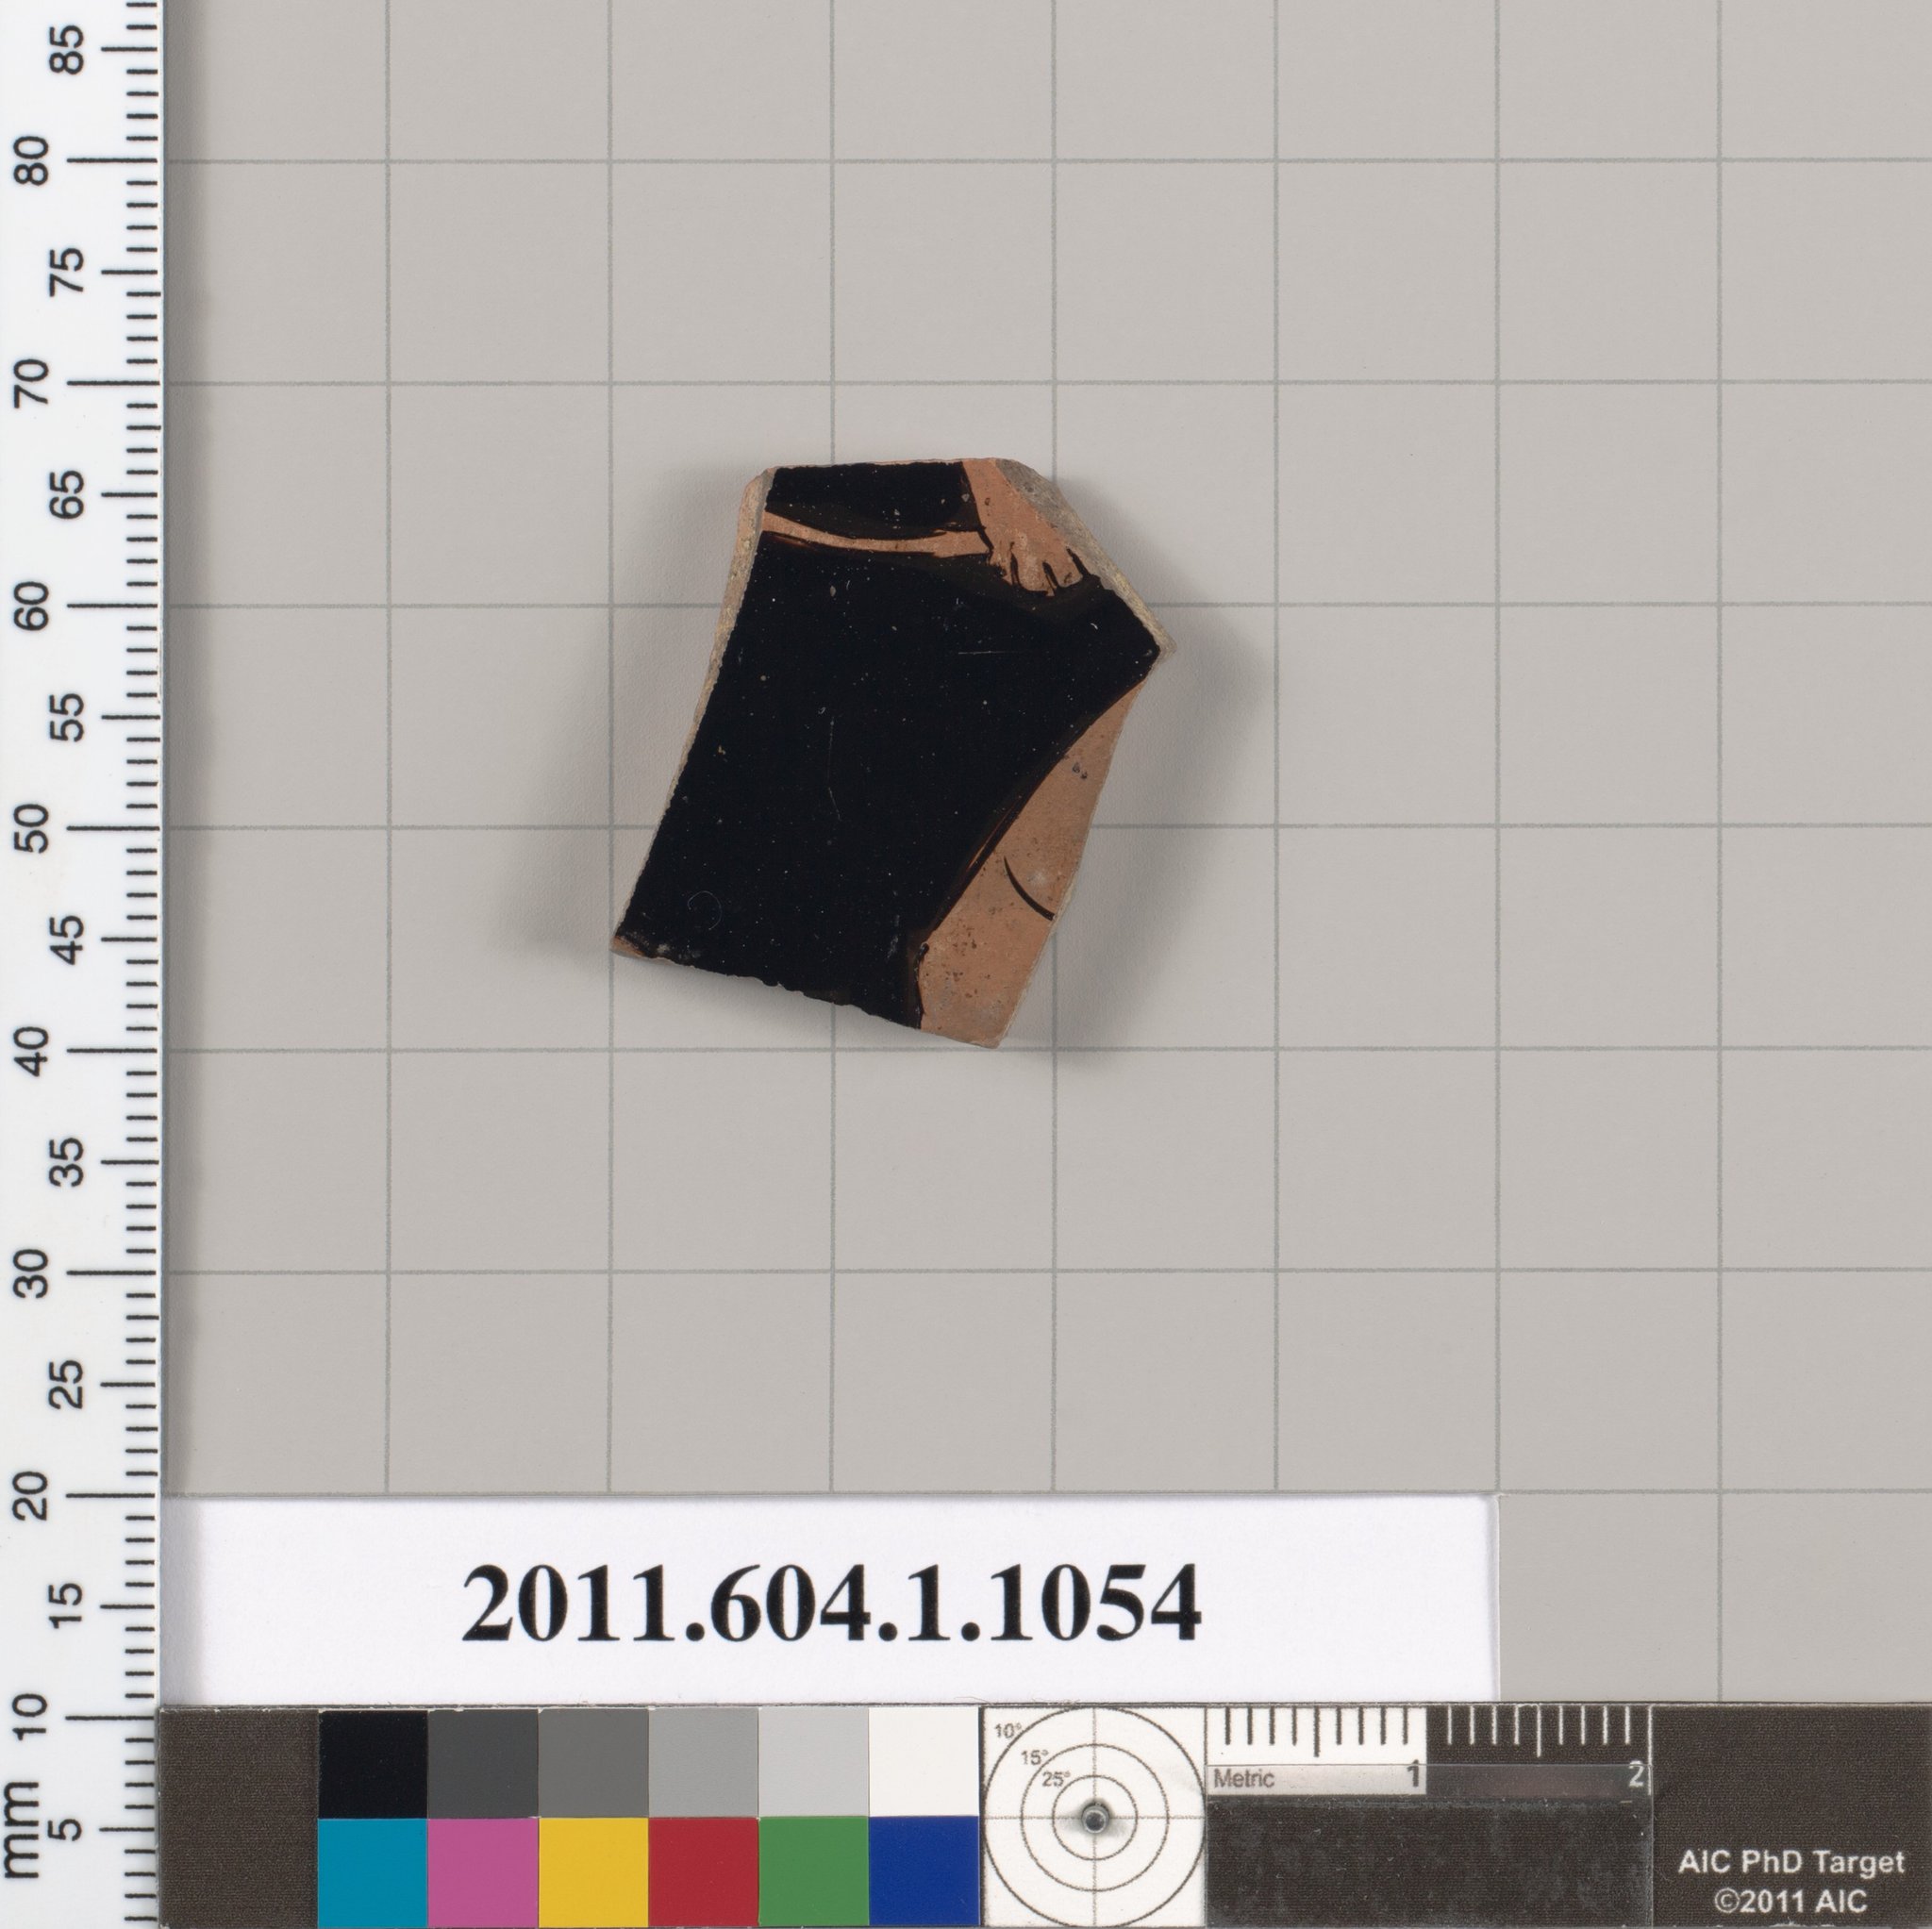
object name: kylix fragment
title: Terracotta fragment of a kylix (drinking cup)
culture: greek, attic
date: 475-451 BCE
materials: terracotta